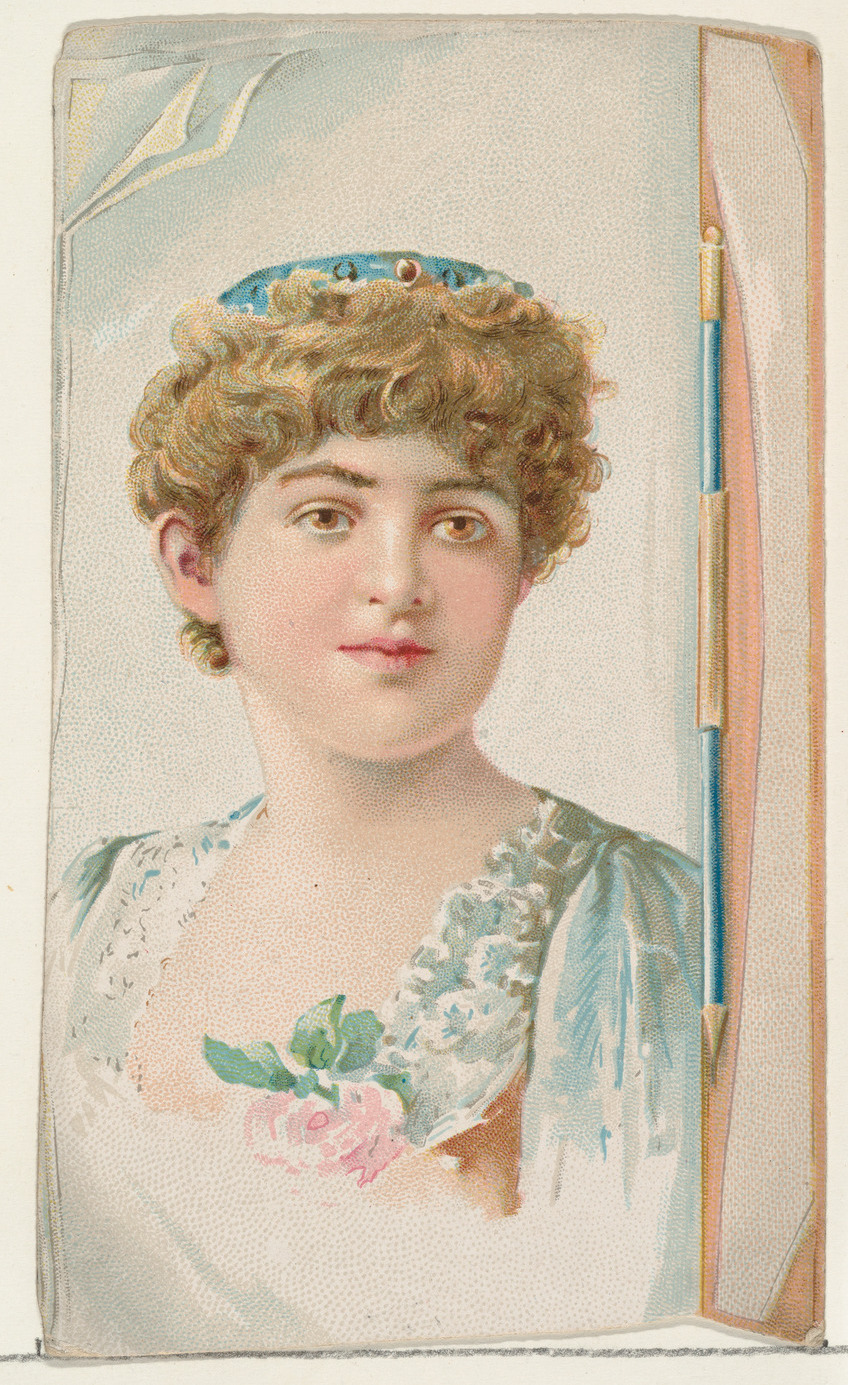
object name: print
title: Pad and Pencil, from the Novelties series (N122) issued by Gail & Ax Tobacco to promote Navy Long Cut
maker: gail & ax tobacco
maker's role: publisher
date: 1889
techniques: color lithograph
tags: women